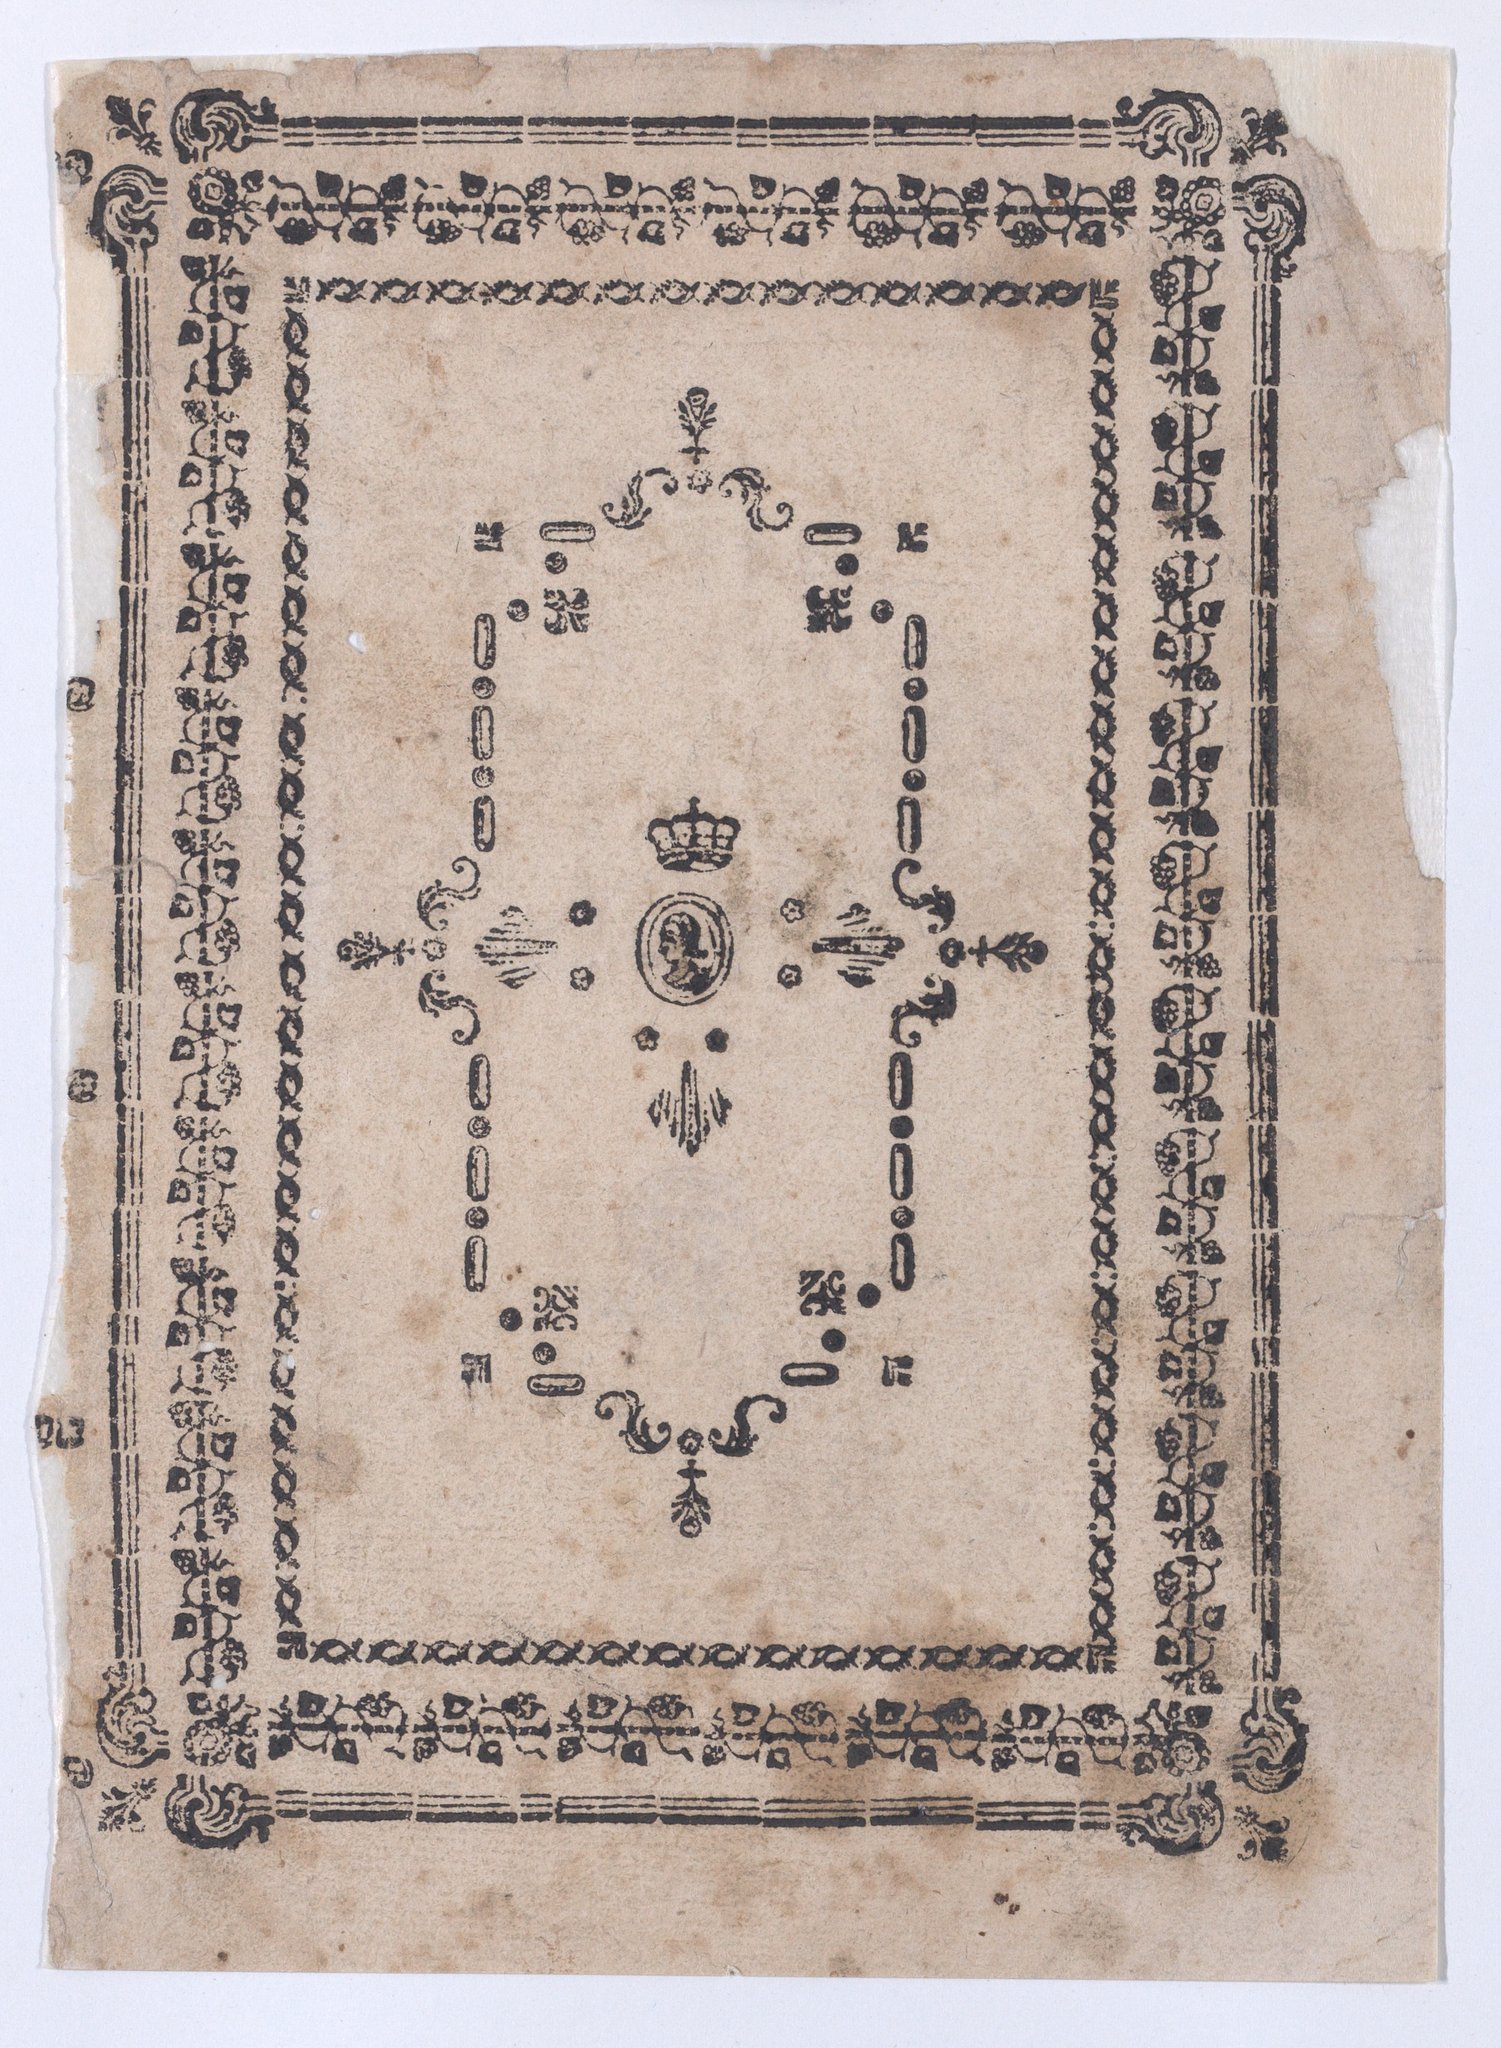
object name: print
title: Sheet with rectangular design, possibly carpet design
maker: Anonymous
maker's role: artist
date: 1801-1900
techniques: relief print